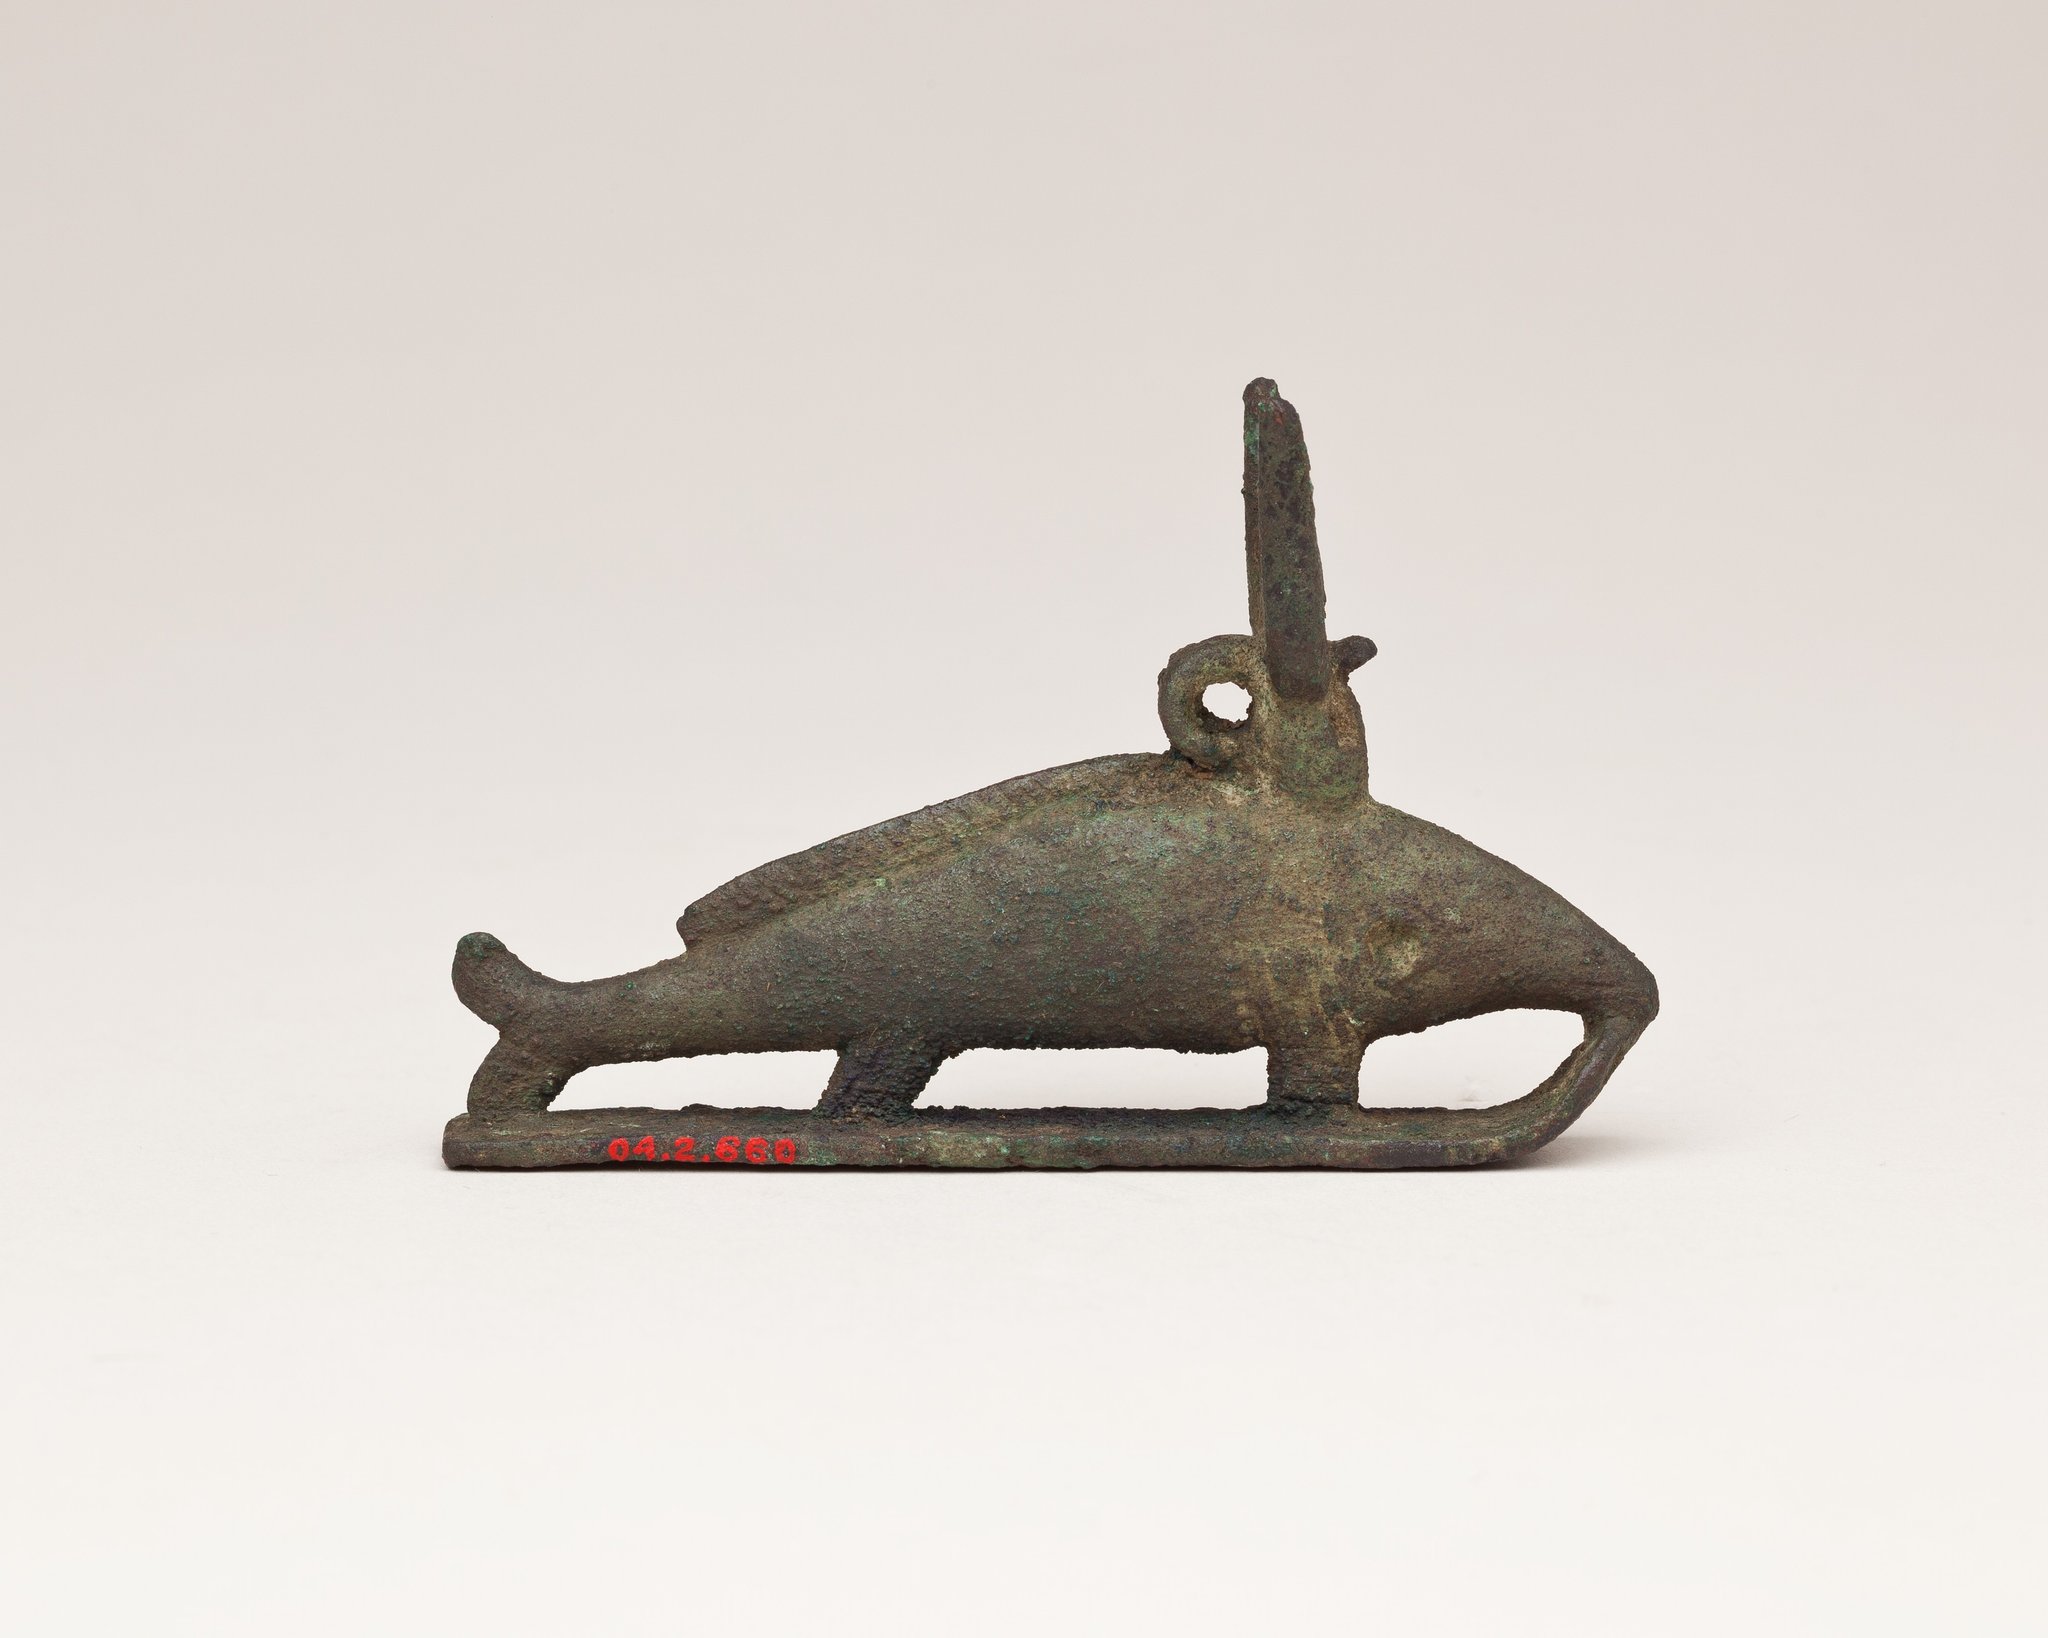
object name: amulet, oxyrhynchus fish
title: Oxyrhynchus fish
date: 664-630 BCE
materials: alloy, bronze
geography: egypt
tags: fish